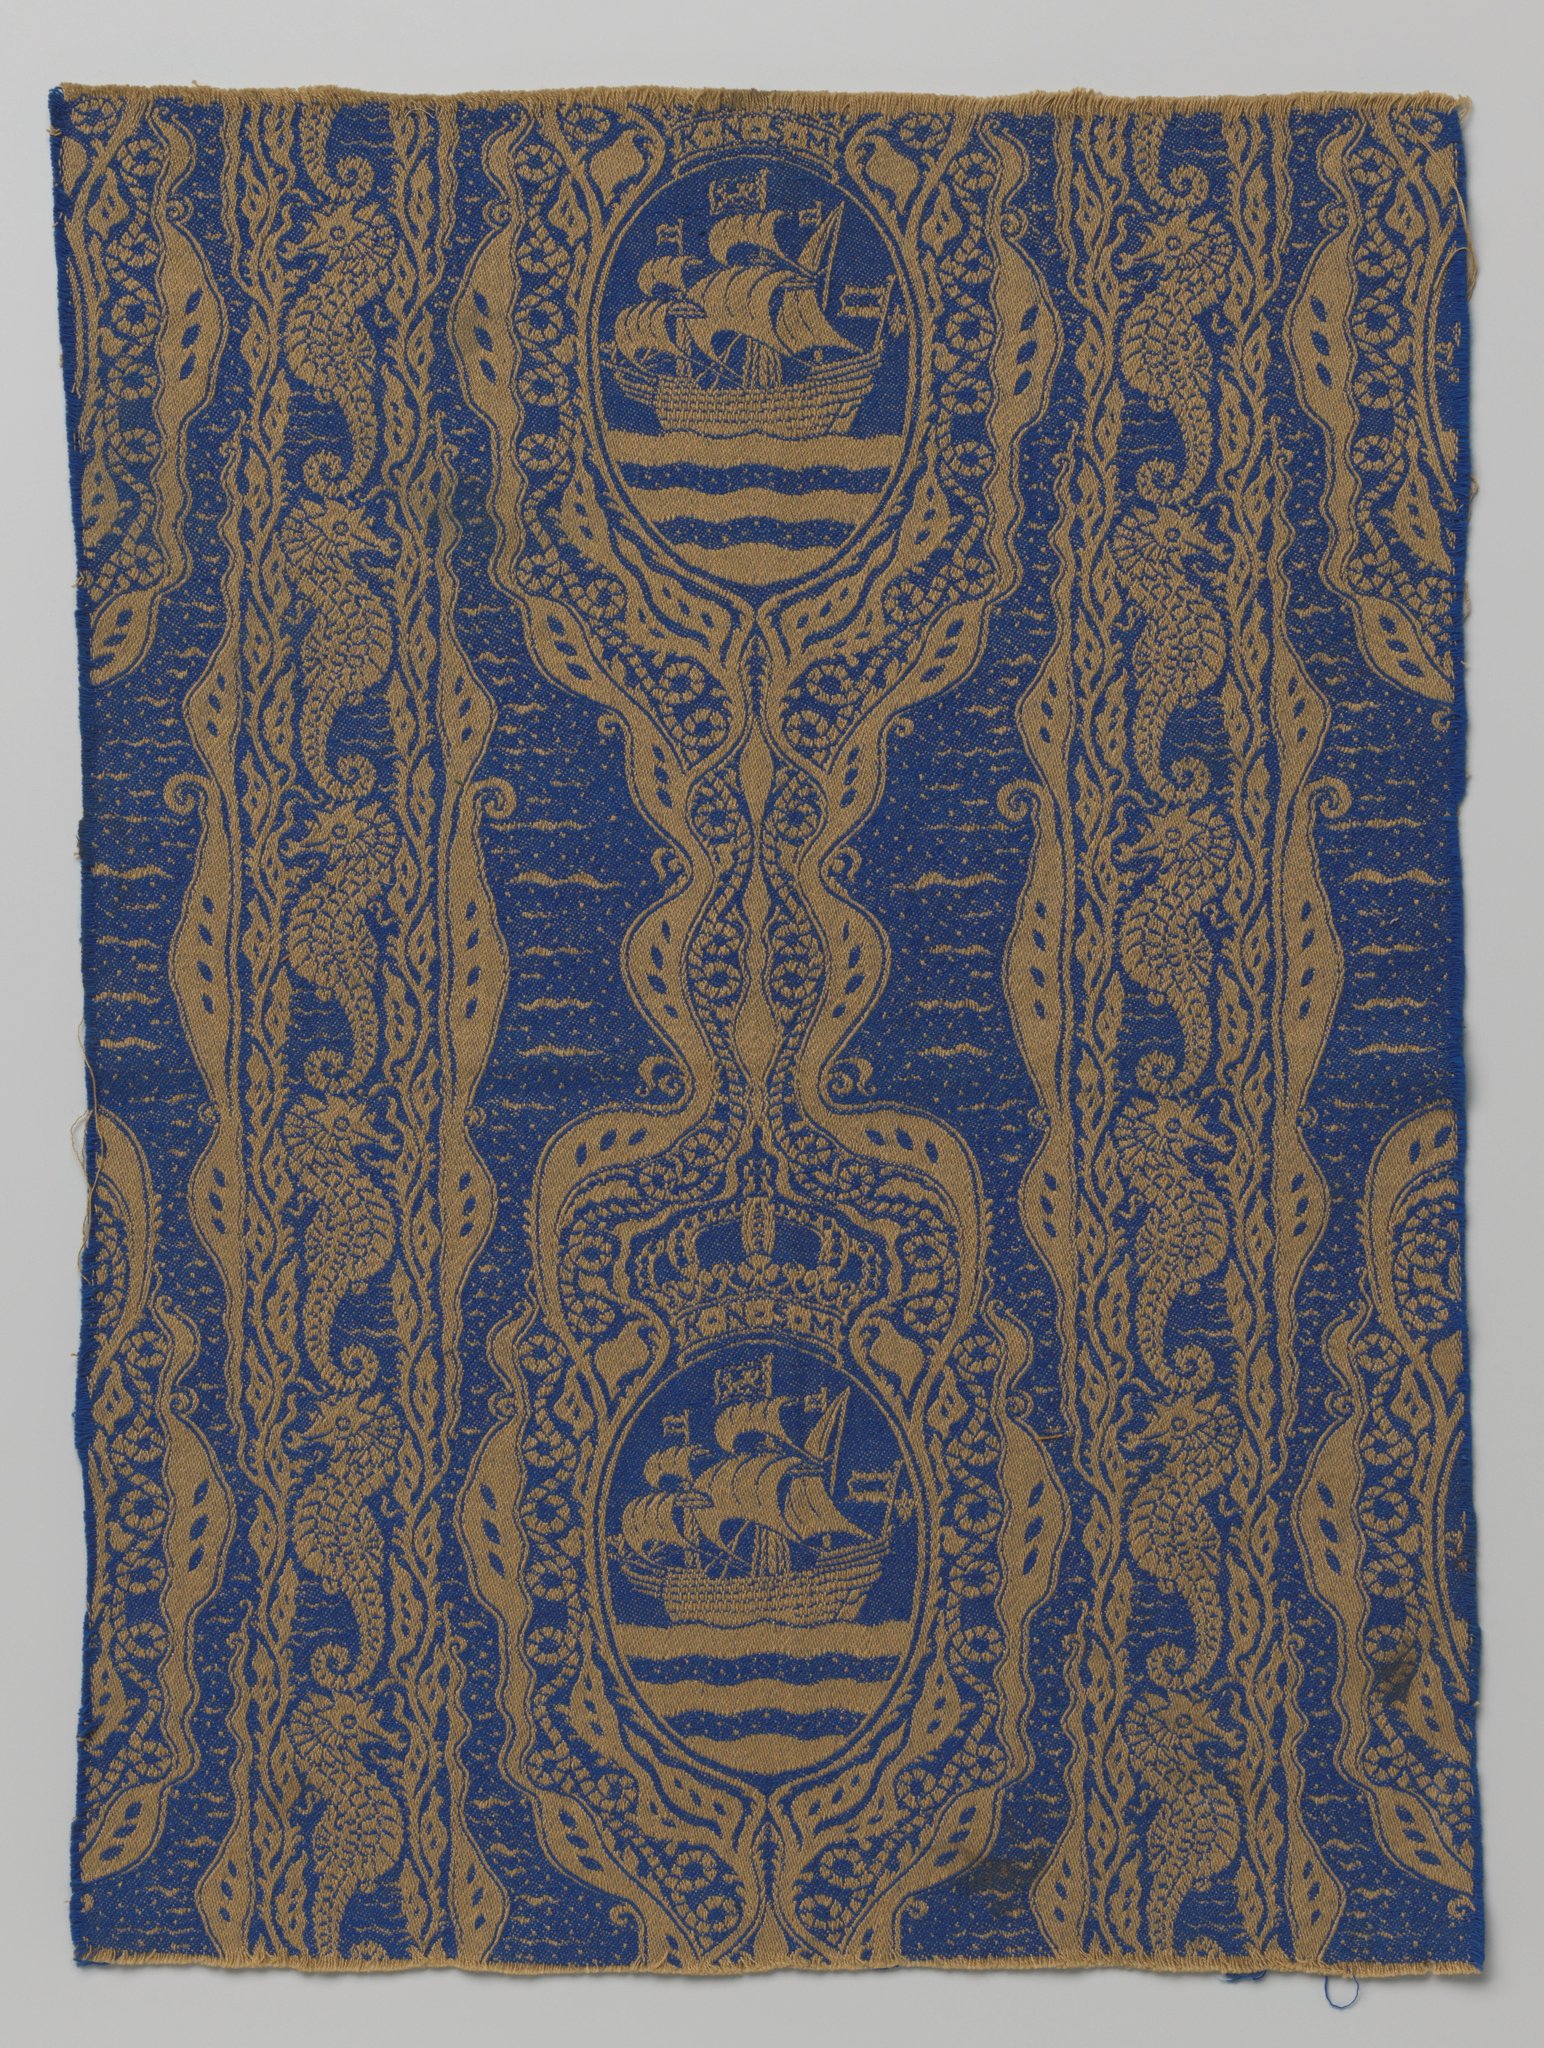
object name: gordijnstof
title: Gordijnstof met zeepaarden en het embleem van de K.N.S.M.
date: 1900-1925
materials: cotton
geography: netherlands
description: Gordijnstof met zeepaarden en het embleem van de K.N.S.M. Helblauwe inslag op gele ketting. Fragment.